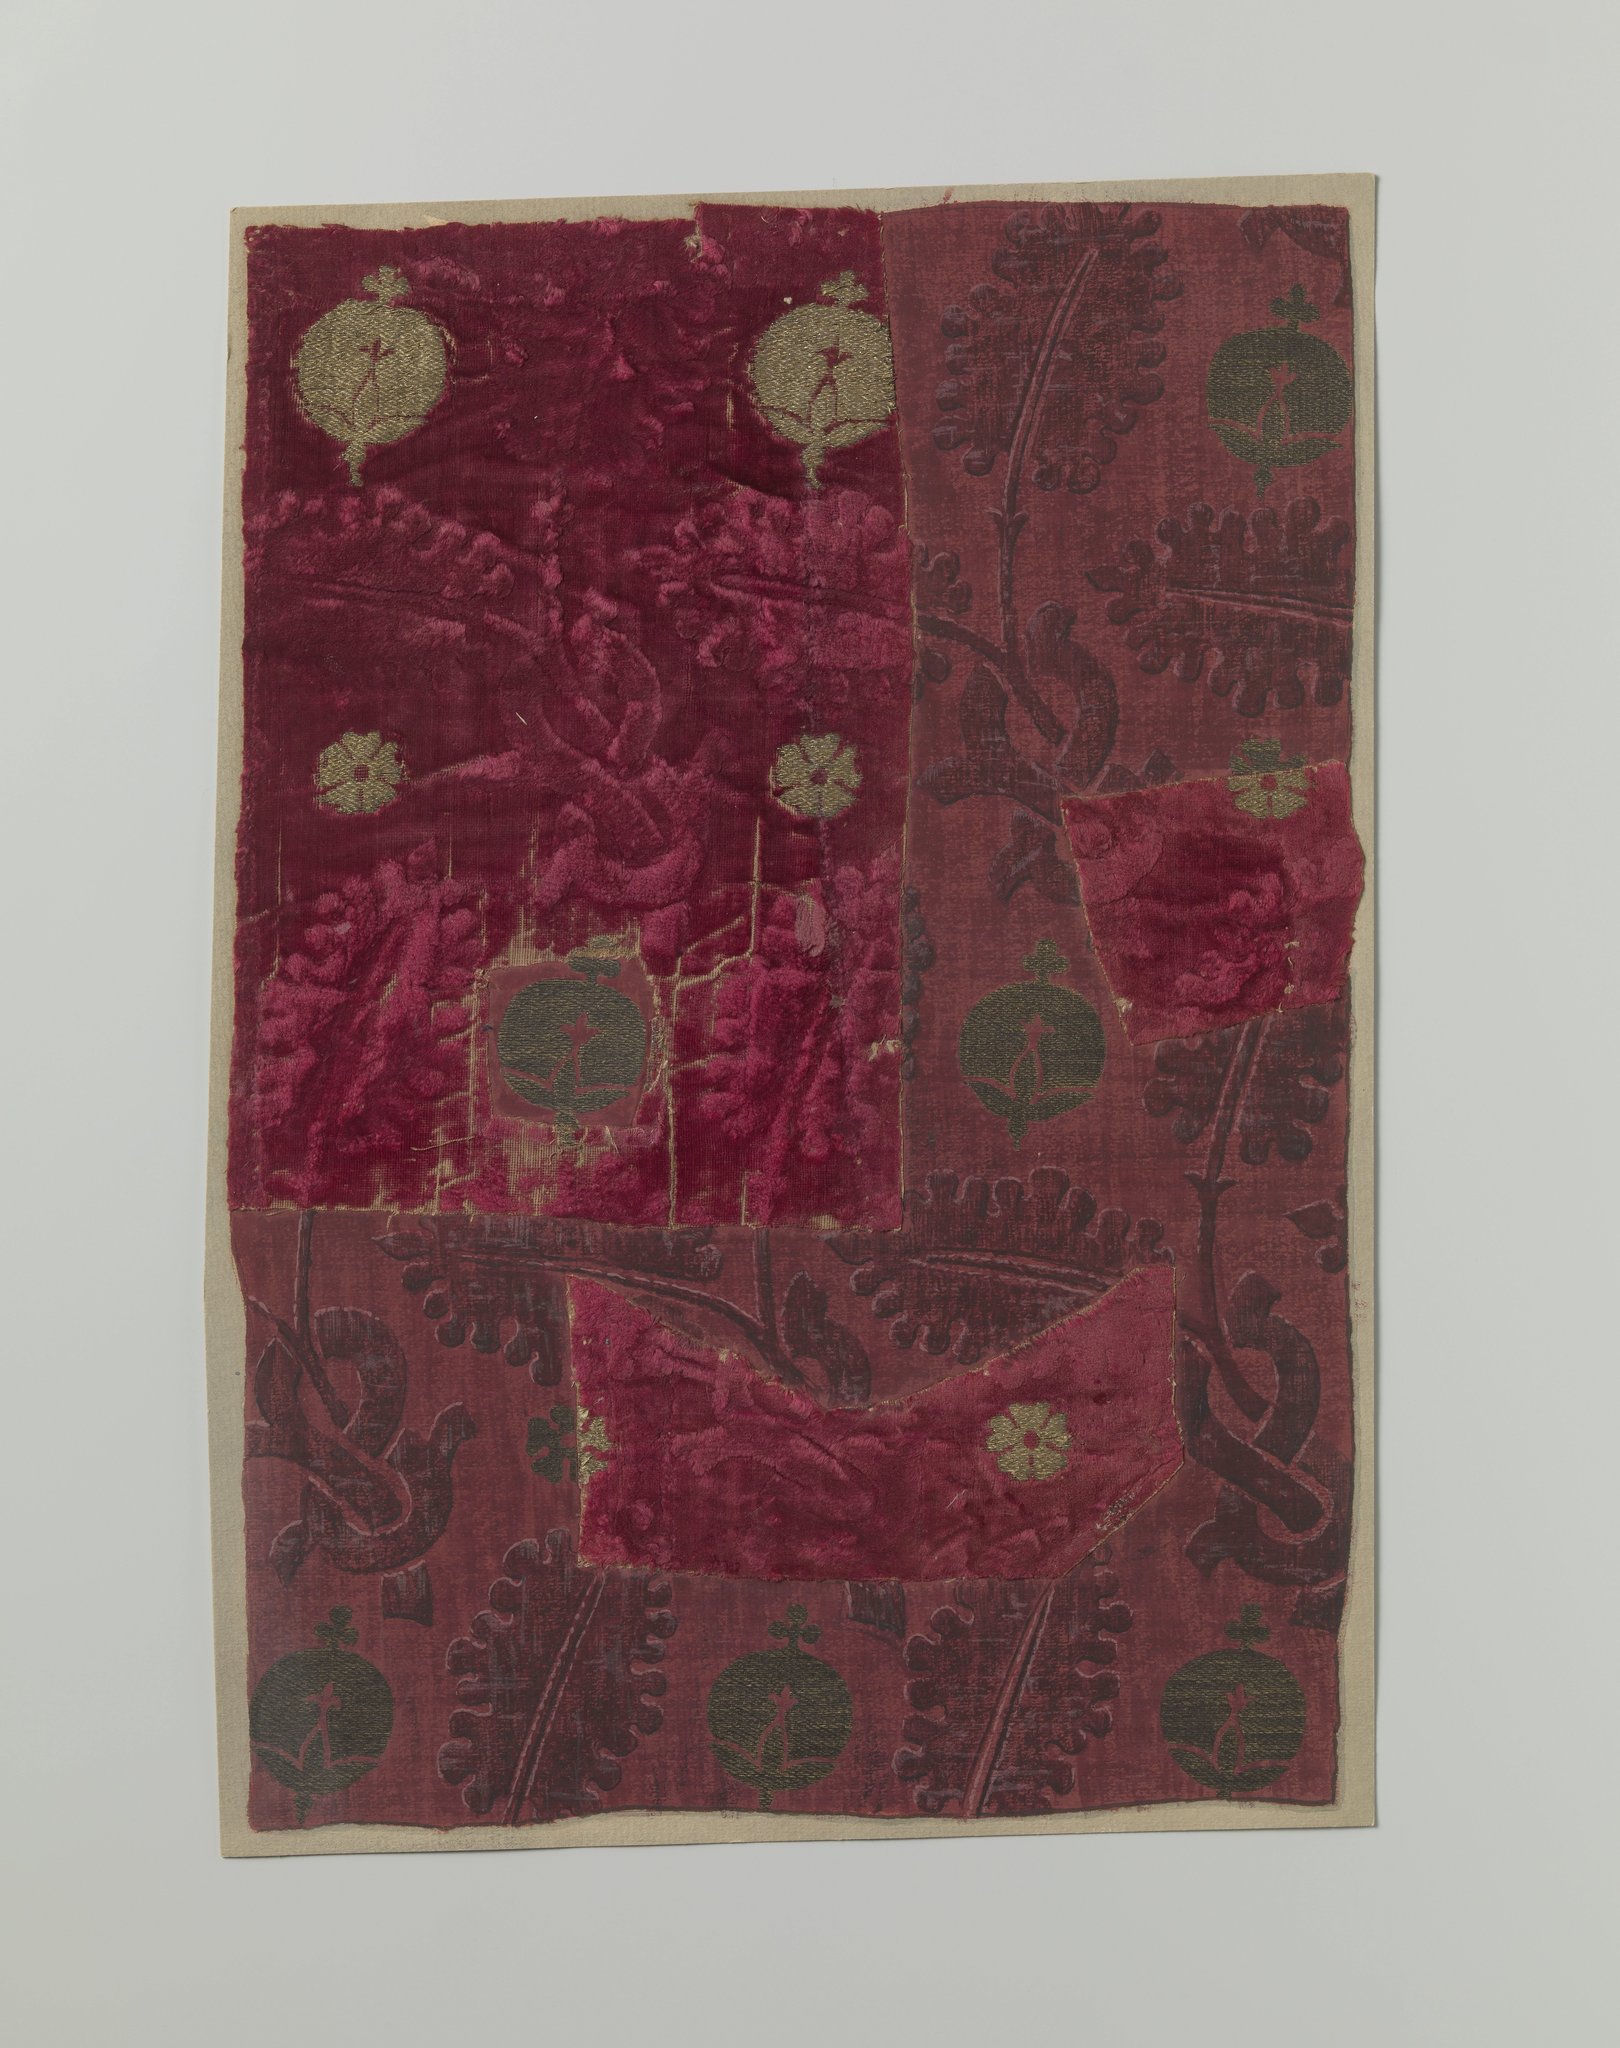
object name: brokaatfluweel, fluweelbrokaat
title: Fragment rood fluweelbrokaat met een patroon van florale motieven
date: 1420-1430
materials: gold thread, silk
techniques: brocade, weave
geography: italy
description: Fragment (drie aaneen geplakte delen) rood zijdefluweel met een patroon van horizontaal gerijde gelobde bladeren aan gevlochten stengel waartussen granaatappels en rozetten van gouddraad. Patroon is aangevuld.